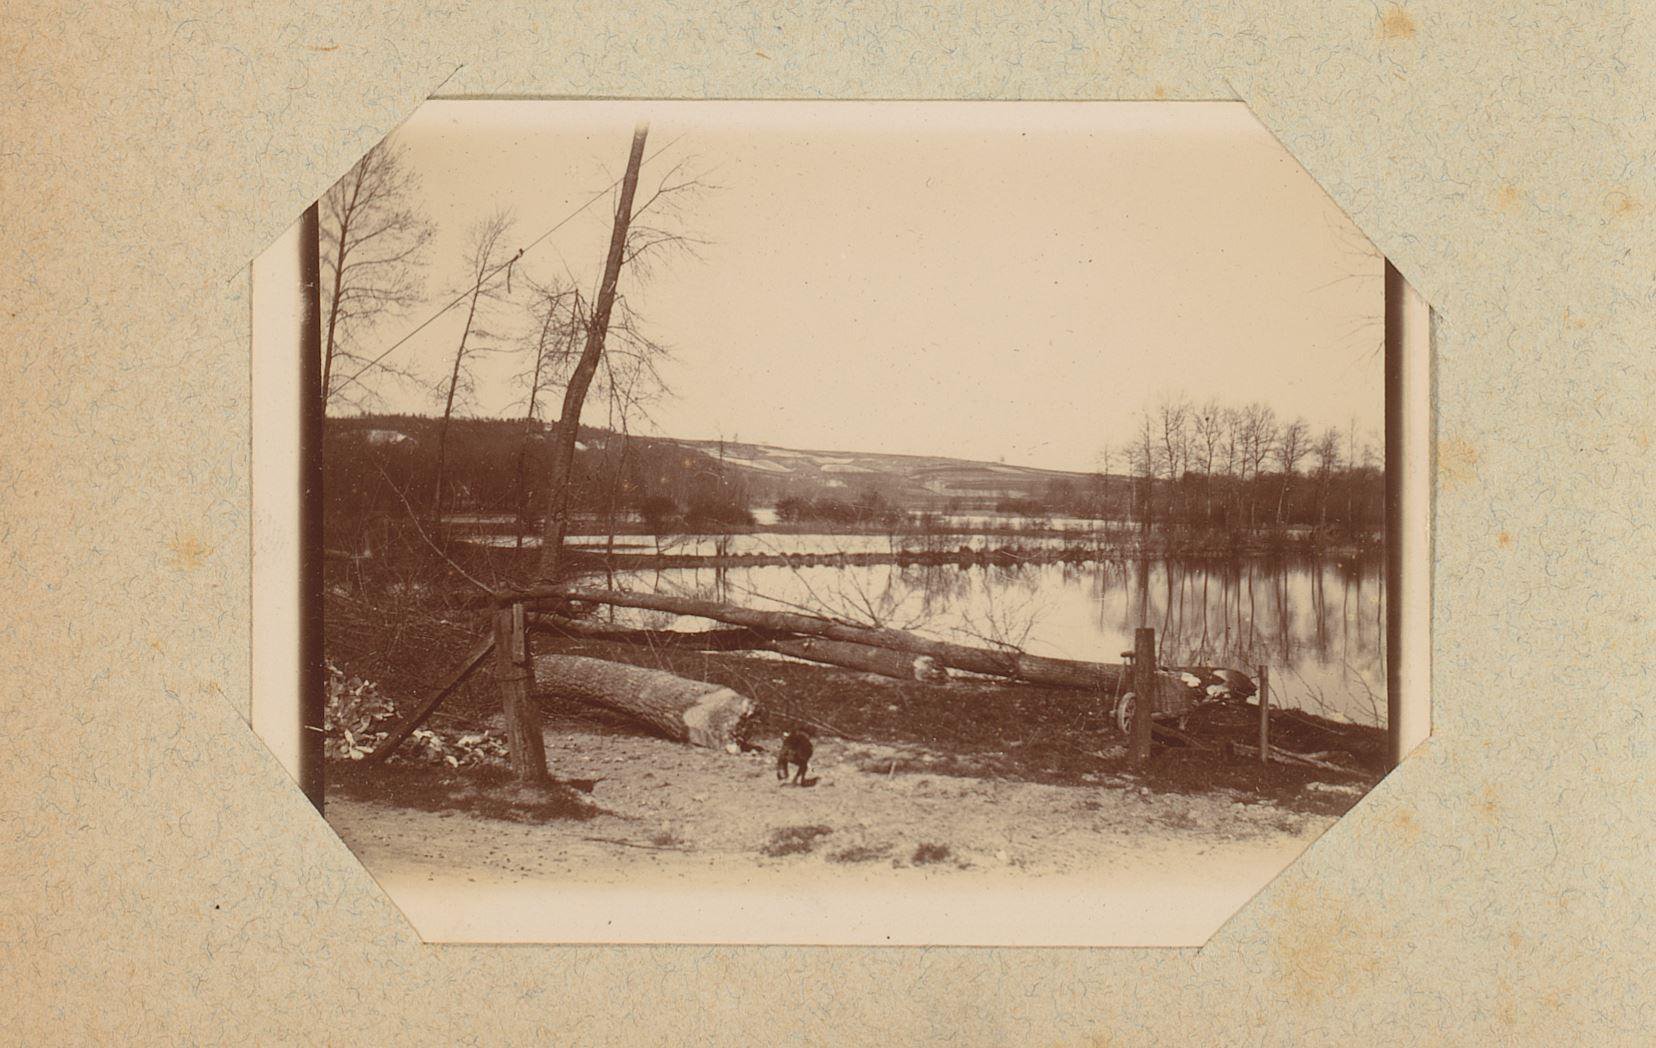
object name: photograph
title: Gevelde bomen langs een rivier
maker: Anonymous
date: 1897-1900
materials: paper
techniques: gelatin silver print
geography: france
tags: trees, france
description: Over de foto is een ander negatief afgedrukt van een voorstelling van bomen.